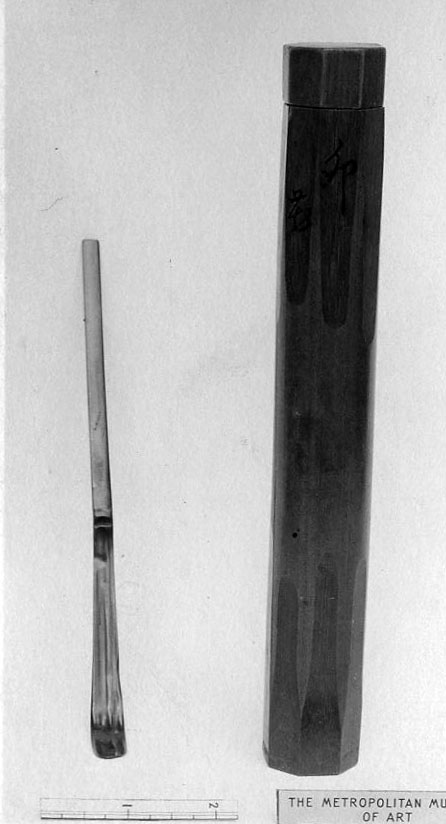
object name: tea scoop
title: Tea Scoop (chashaku)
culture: japanese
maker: sen no rikyū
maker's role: artist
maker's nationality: japanese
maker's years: 1522-1591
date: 1601-1633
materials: wood